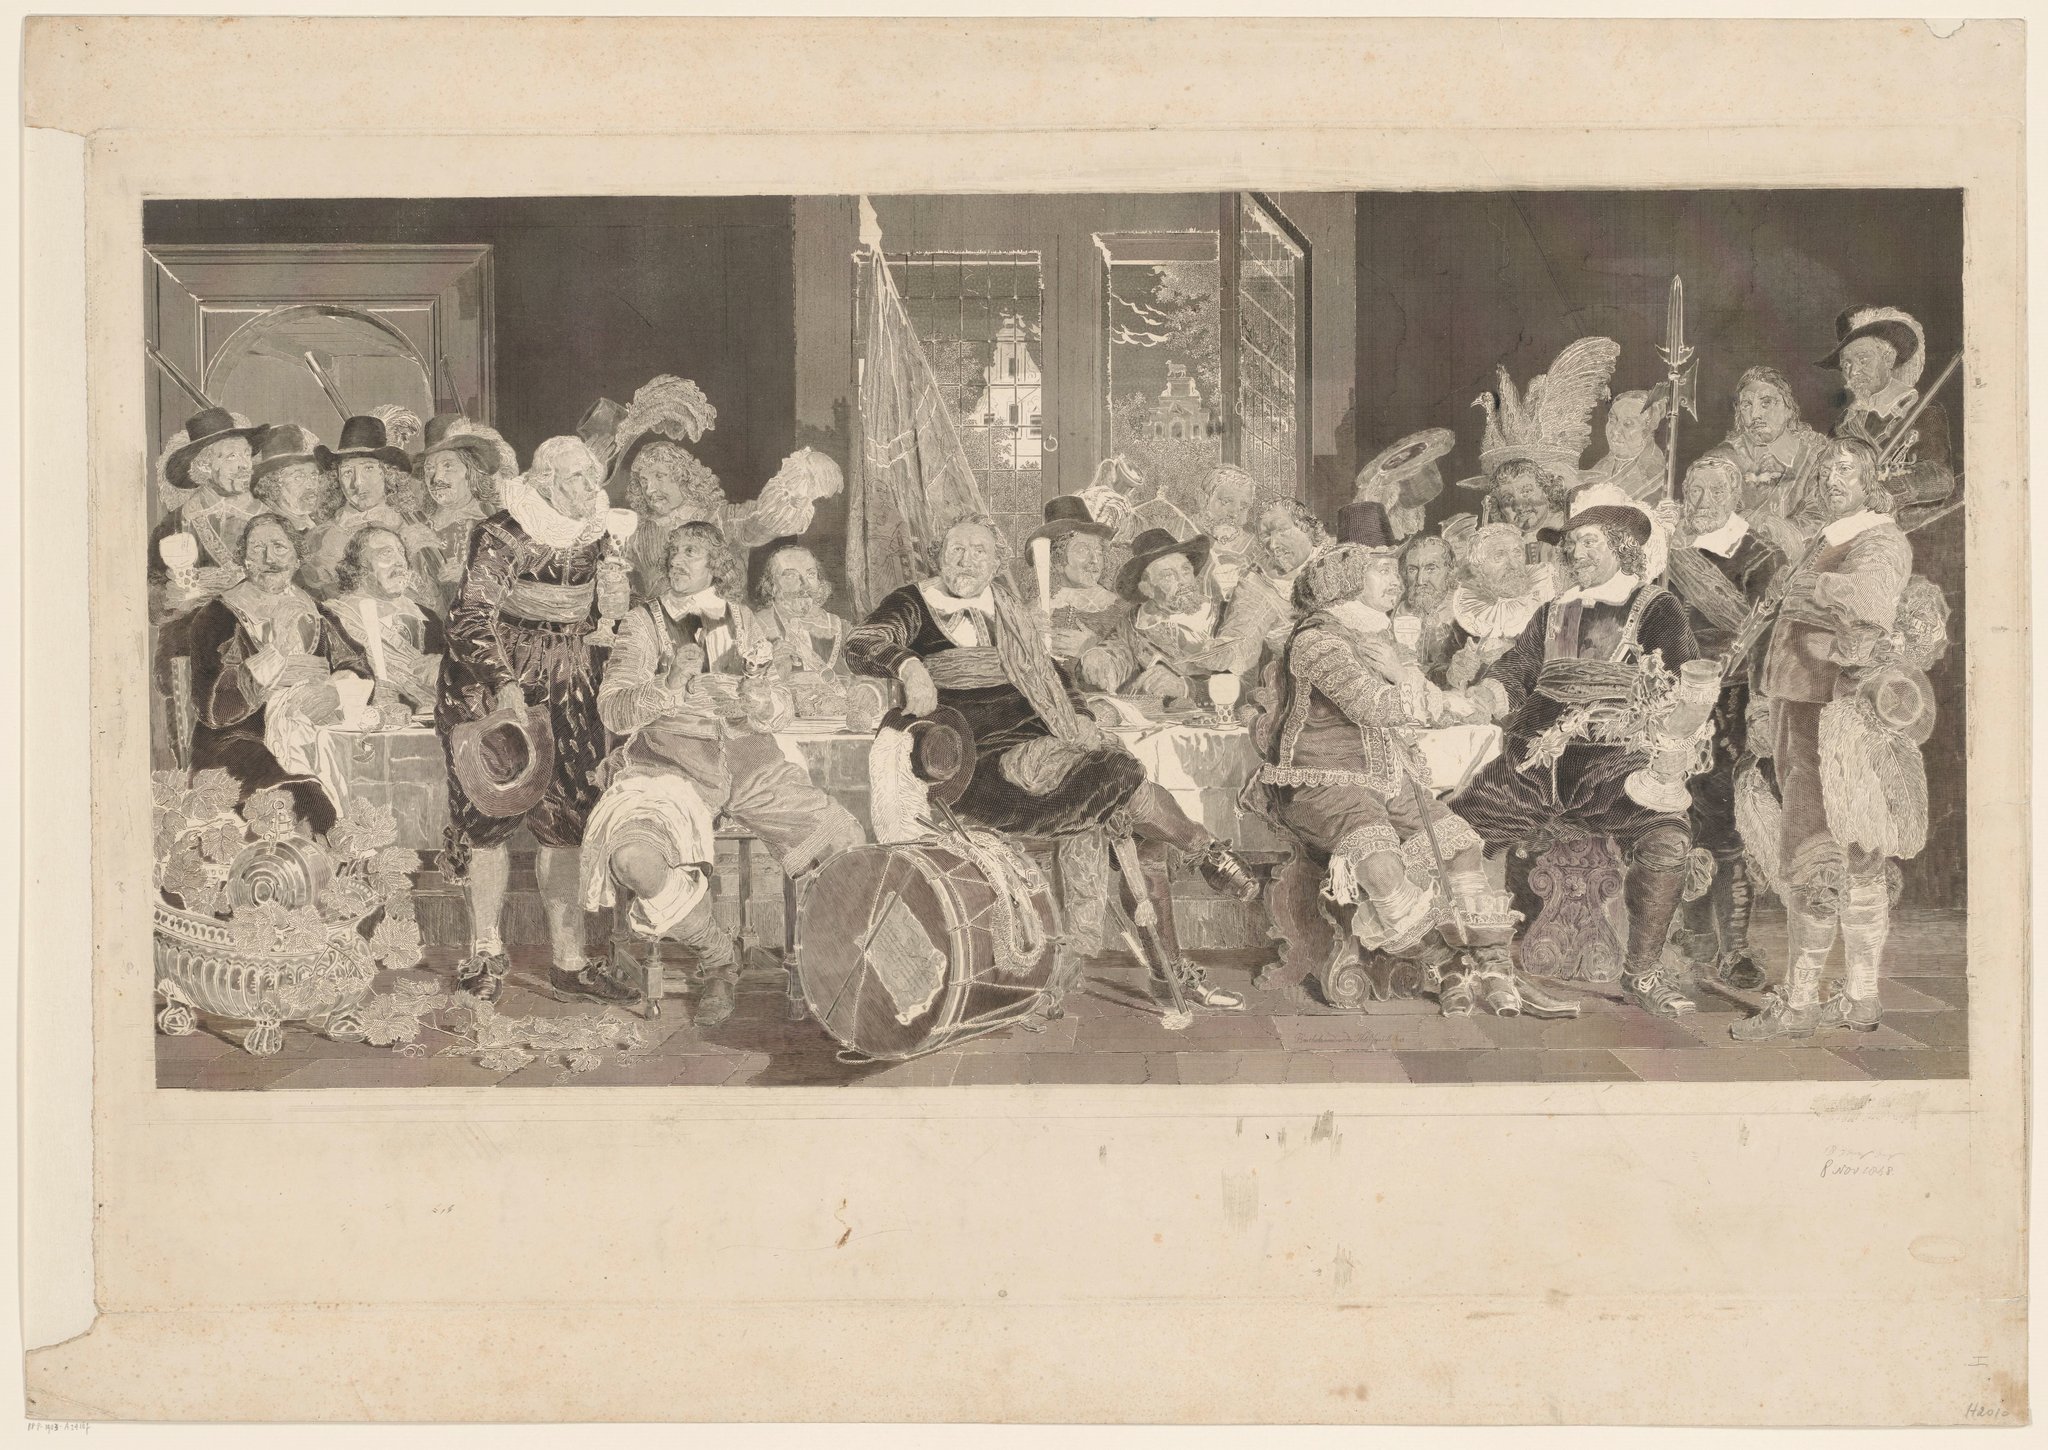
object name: print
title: De schuttersmaaltijd in de Voetboog- of St. Jorisdoelen te Amsterdam ter viering van het sluiten van de vrede van Munster, 18 juni 1648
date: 1848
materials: paper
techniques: engraving, etching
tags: amsterdam, mayor, cornelis witsen, warfare; military affairs (+ citizen soldiery, civil guard, citizen militia), glass, rummer, celebration meal, feast, banquet, (military) flags and standards, private festivities, merry company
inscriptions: collector's mark: Lugt 2228, check stamp: ‘François Buffa & Fils/ Amsterdam’